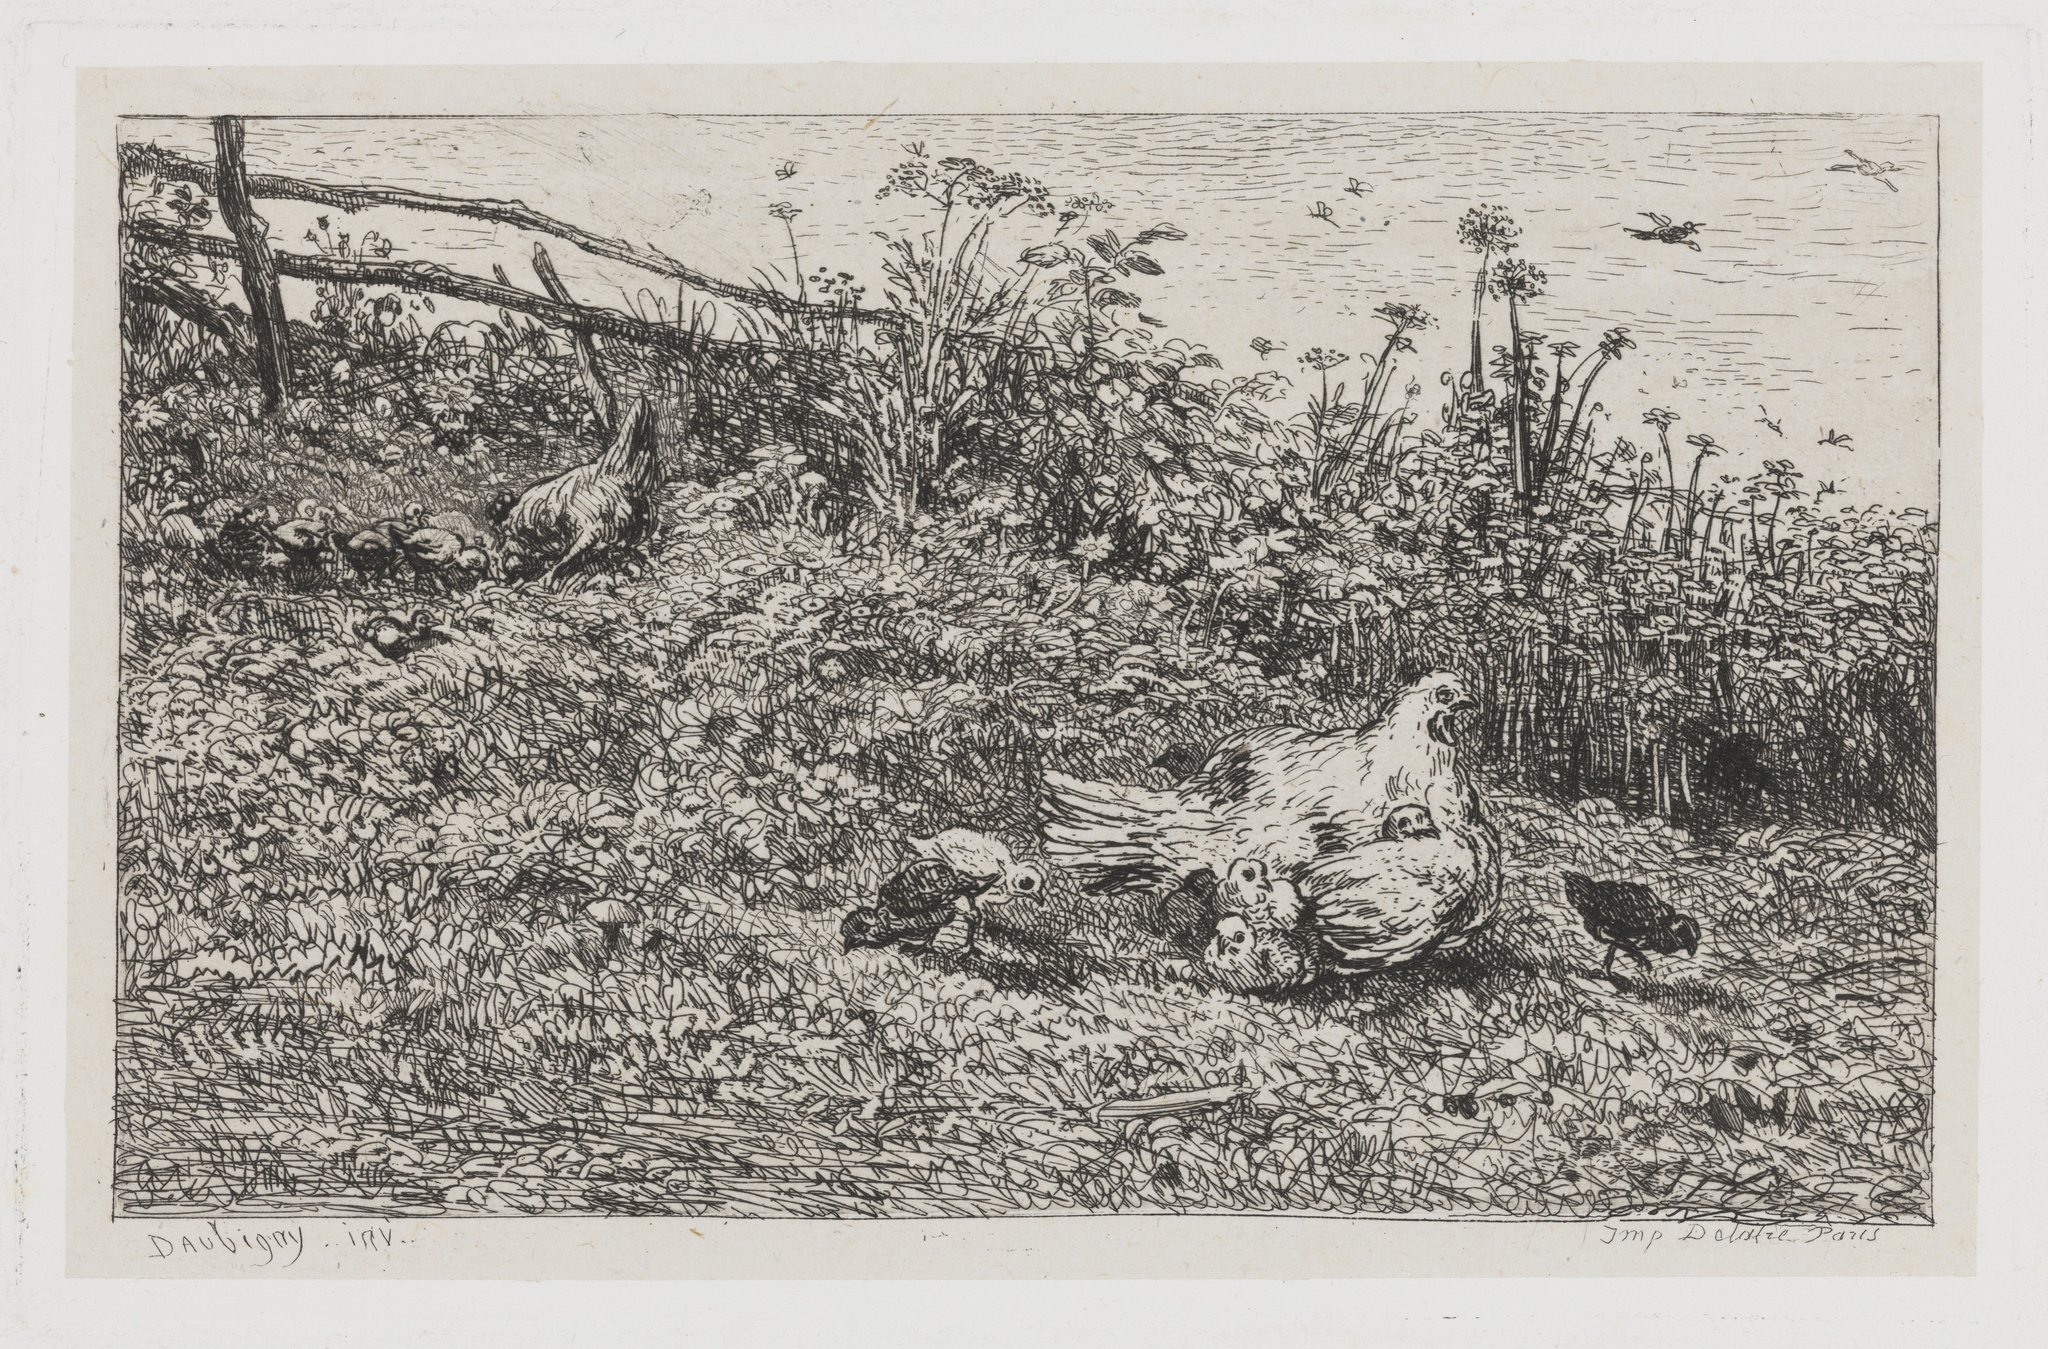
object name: print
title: La Poule et ses Poussins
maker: charles-françois daubigny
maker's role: artist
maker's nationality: french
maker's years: 1817-1878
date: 1860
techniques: printmaking, etching